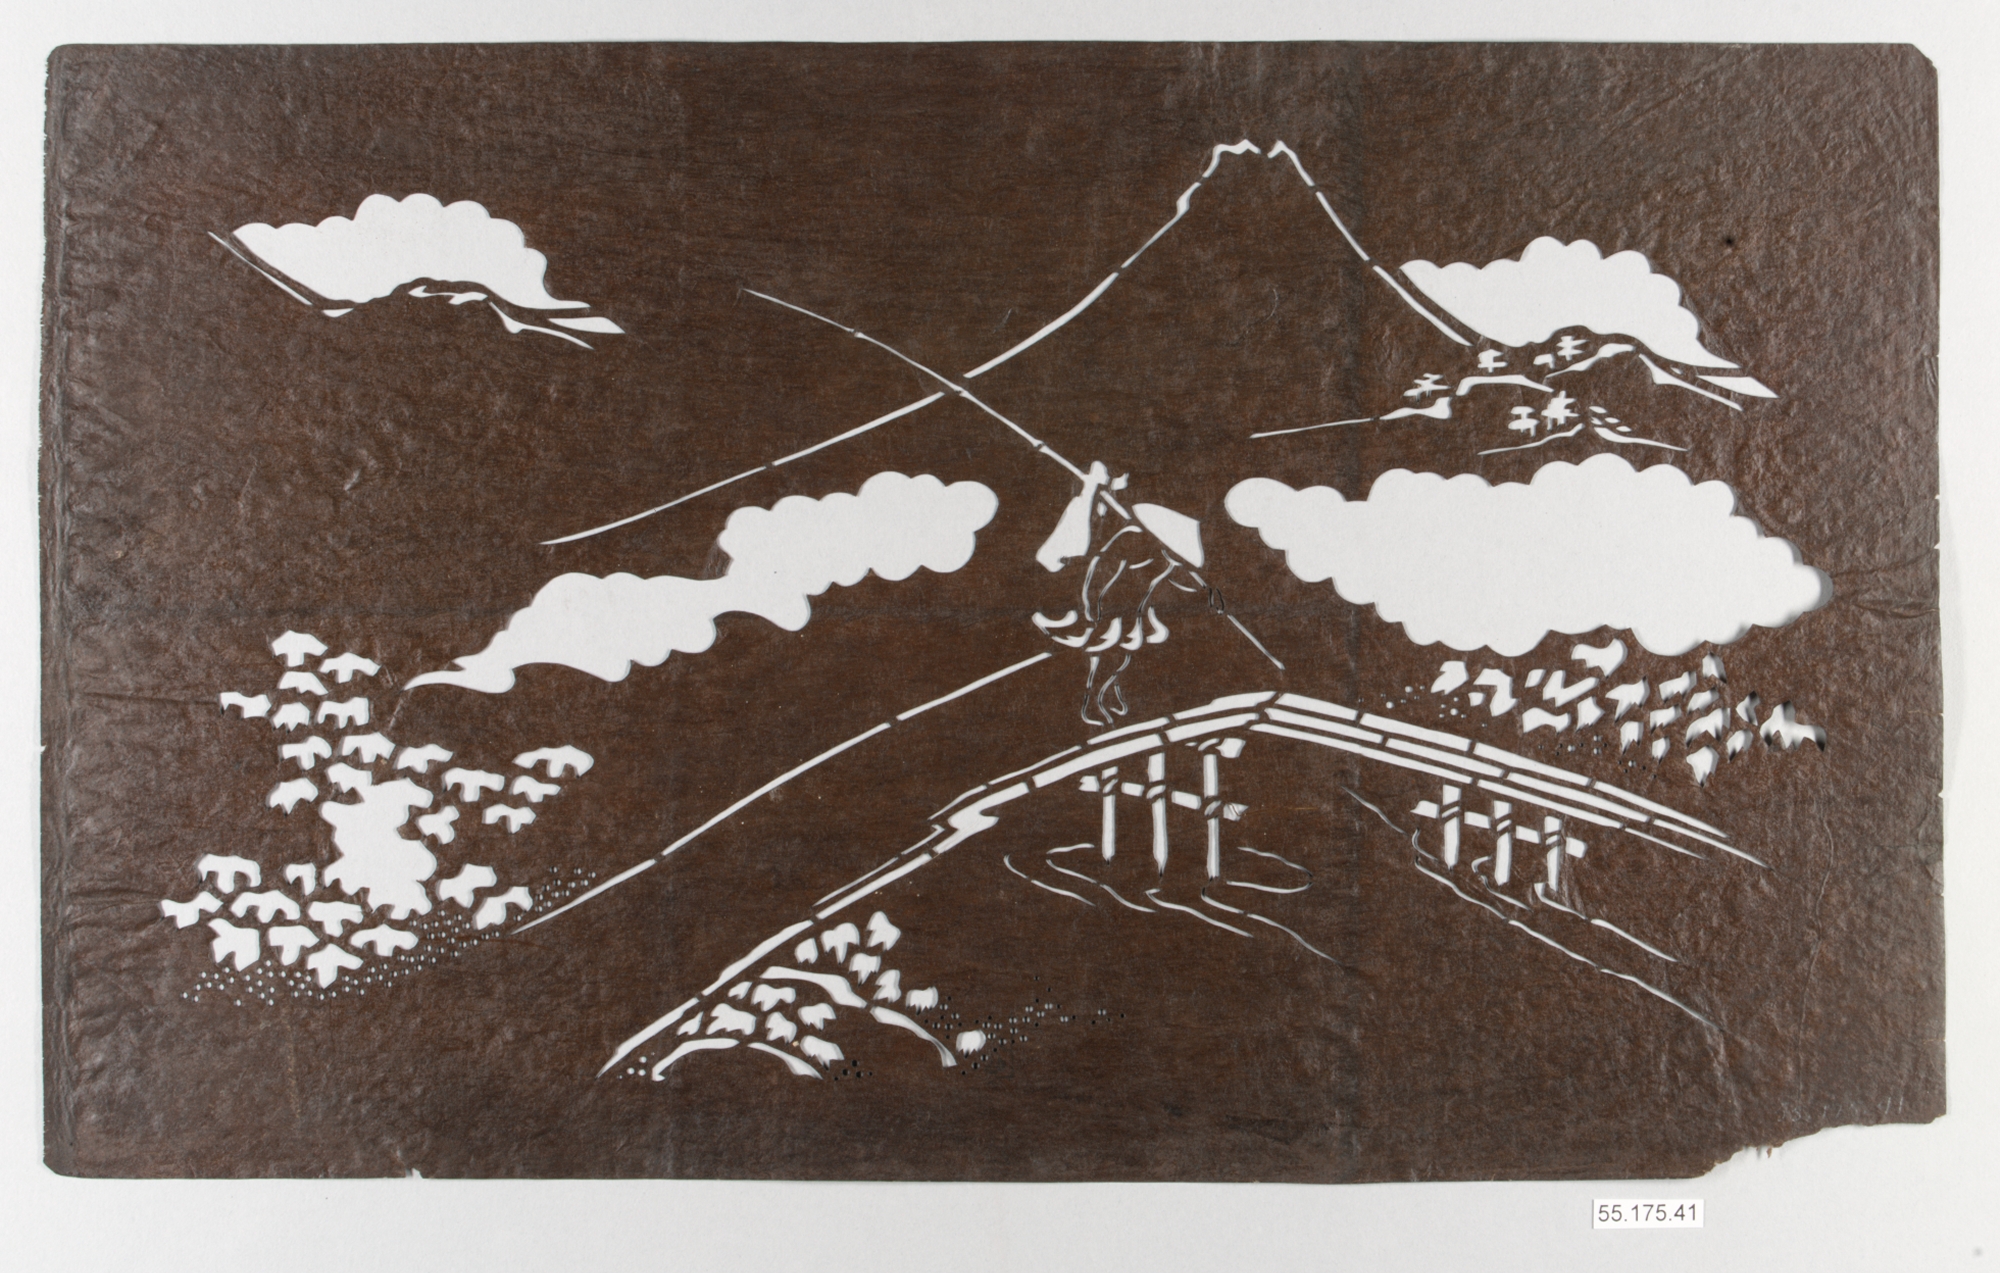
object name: stencil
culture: japanese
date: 1801-1900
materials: paper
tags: human figures,bridges,landscapes